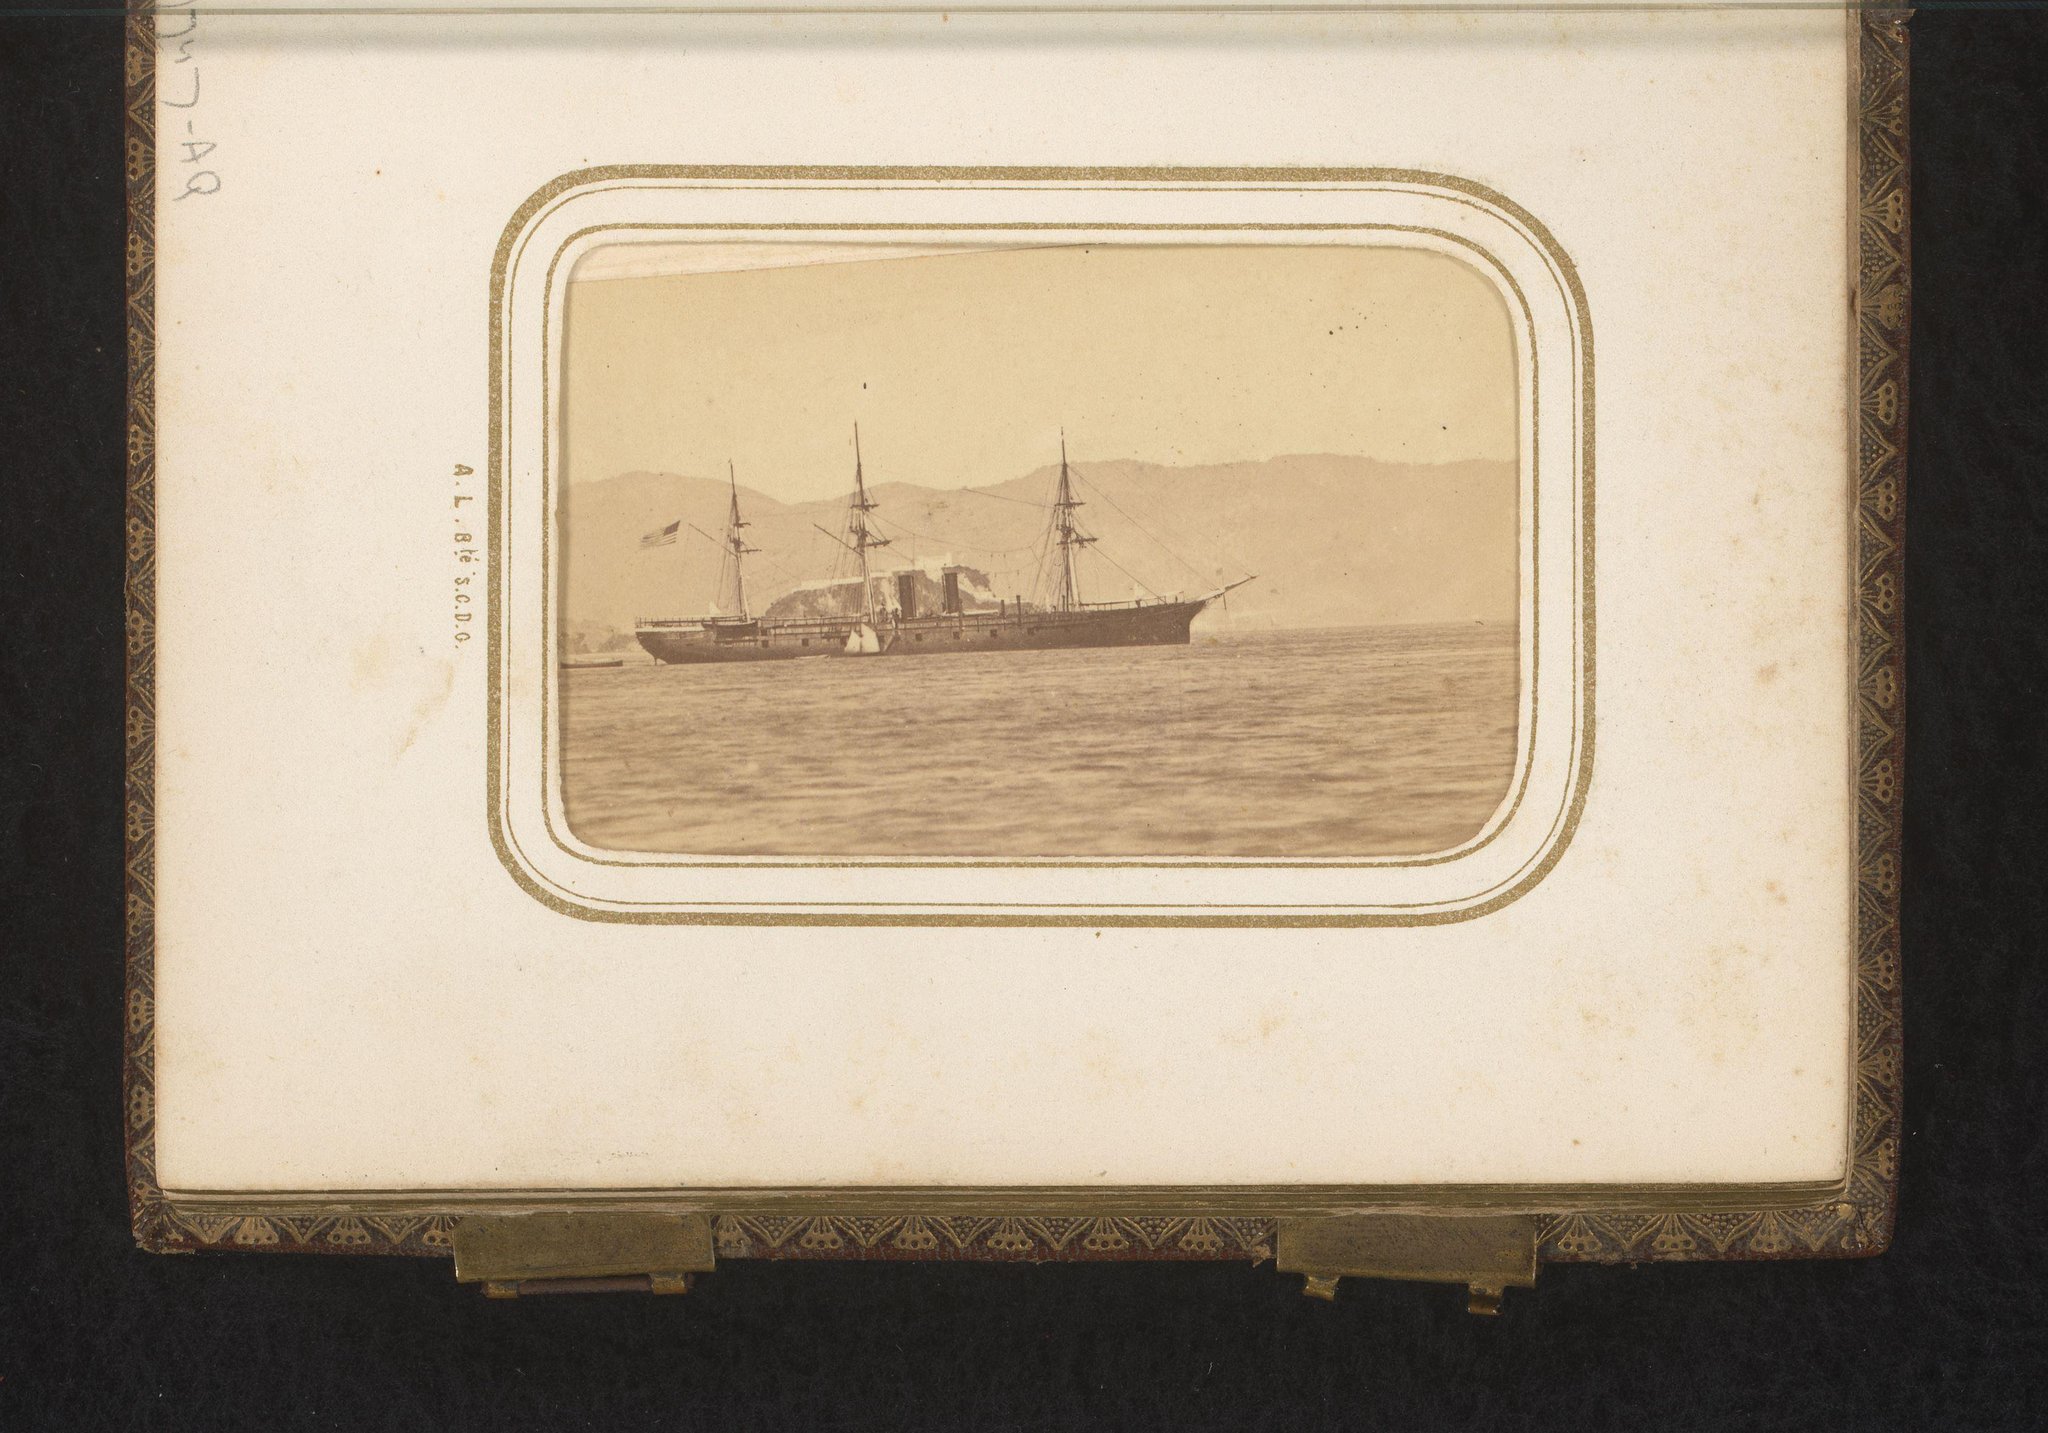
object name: carte de visite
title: Schip op zee voor gebergte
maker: marc ferrez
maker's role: fotograaf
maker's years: 1843-1923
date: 1860-1870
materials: cardboard, photographic support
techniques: albumen print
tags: landscapes with waters, waterscapes, seascapes (in the temperate zone), ships (in general), mountains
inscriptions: inscription: ‘Photographia/ Brazileira/ Marc Ferrez/ Photographo da Marinha Imperial/ e das Construccões Navaes do Rio de Janeiro/ 96, Rua de S. José, 96/ Rio de Janeiro’, inscription: ‘A.L. B.te S.C.D.G.’